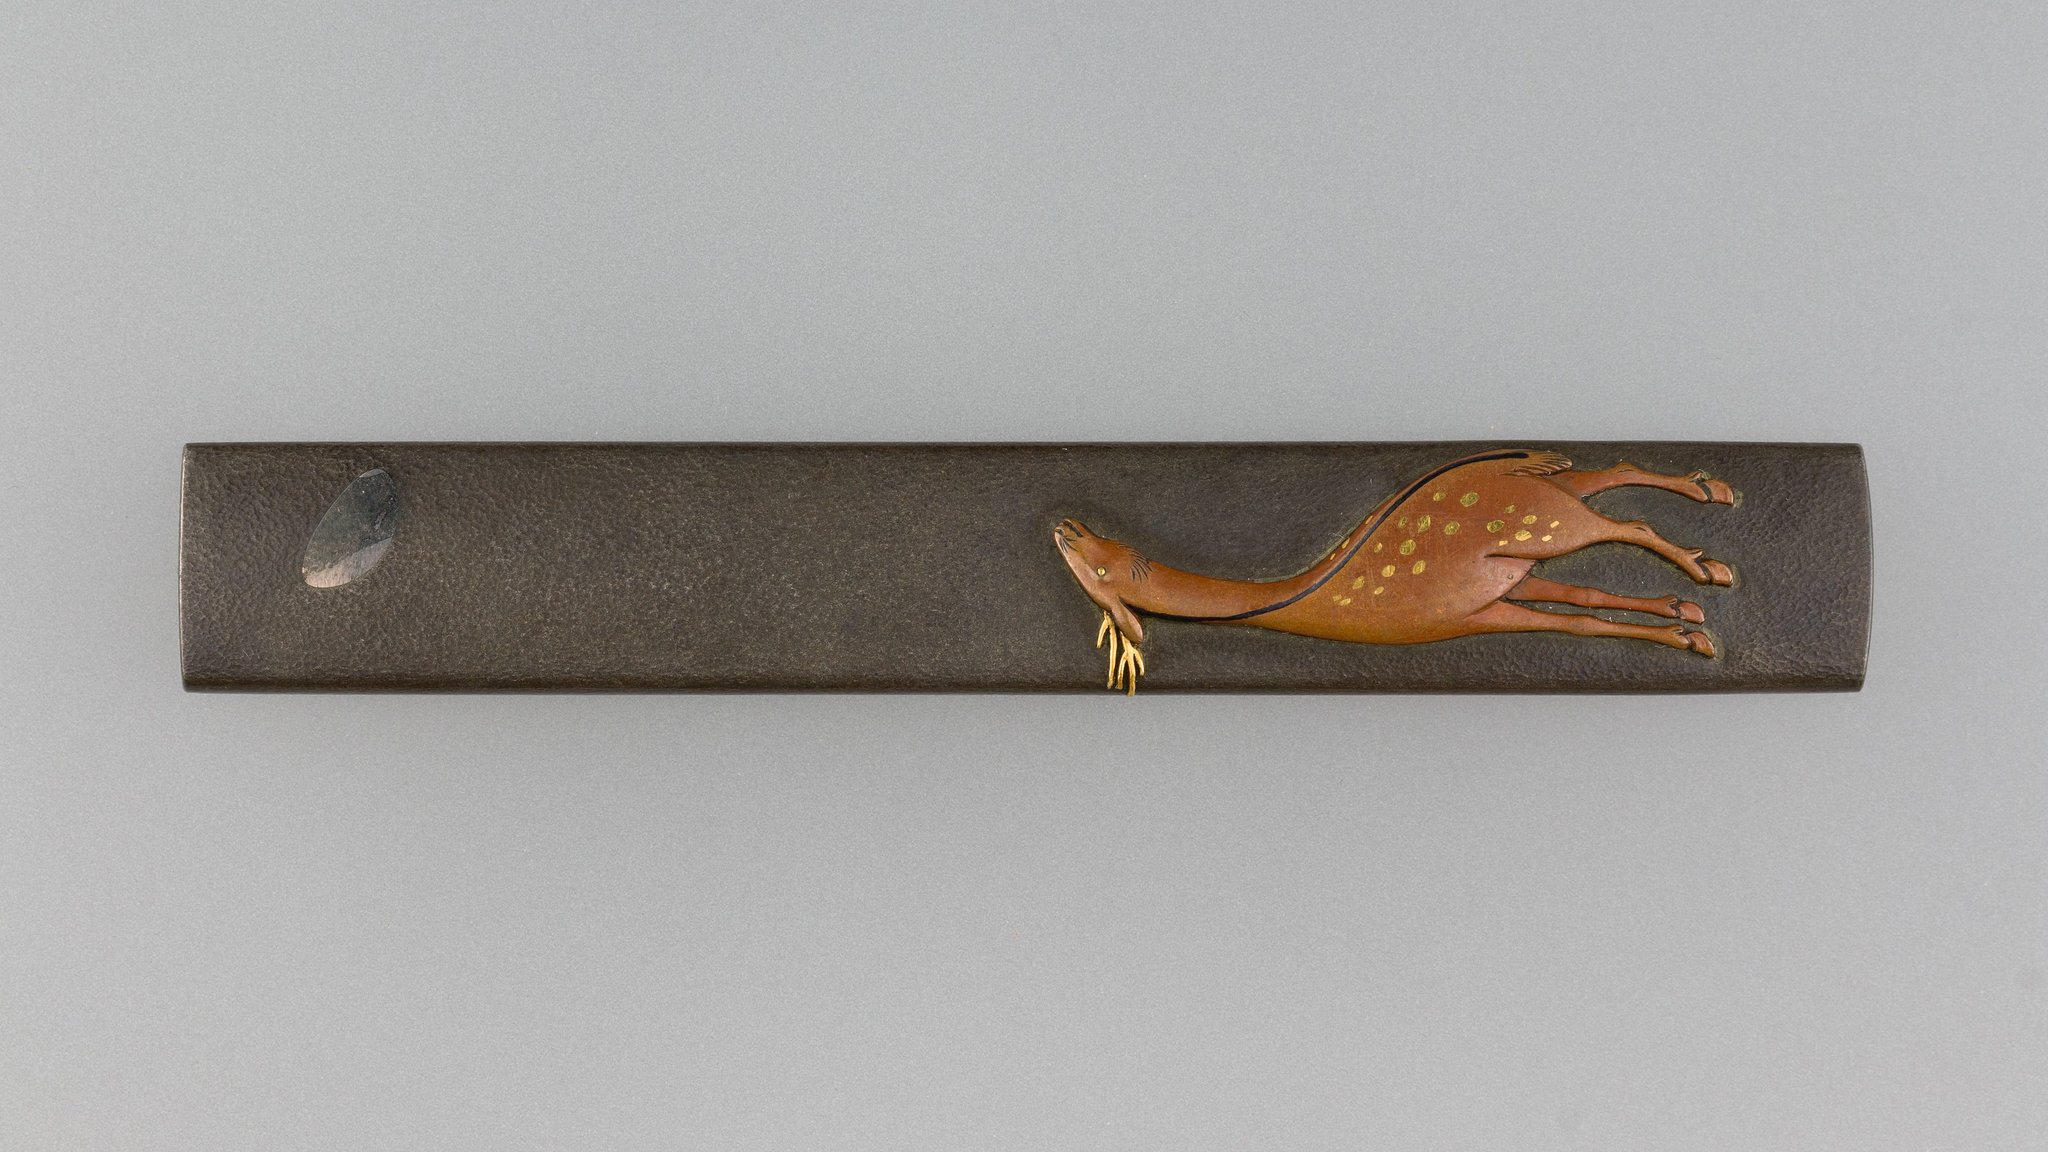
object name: knife handle kozuka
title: Knife Handle (Kozuka)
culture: japanese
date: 1770-1852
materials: copper, gold alloy, silver alloy, gold, silver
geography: japan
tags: deer